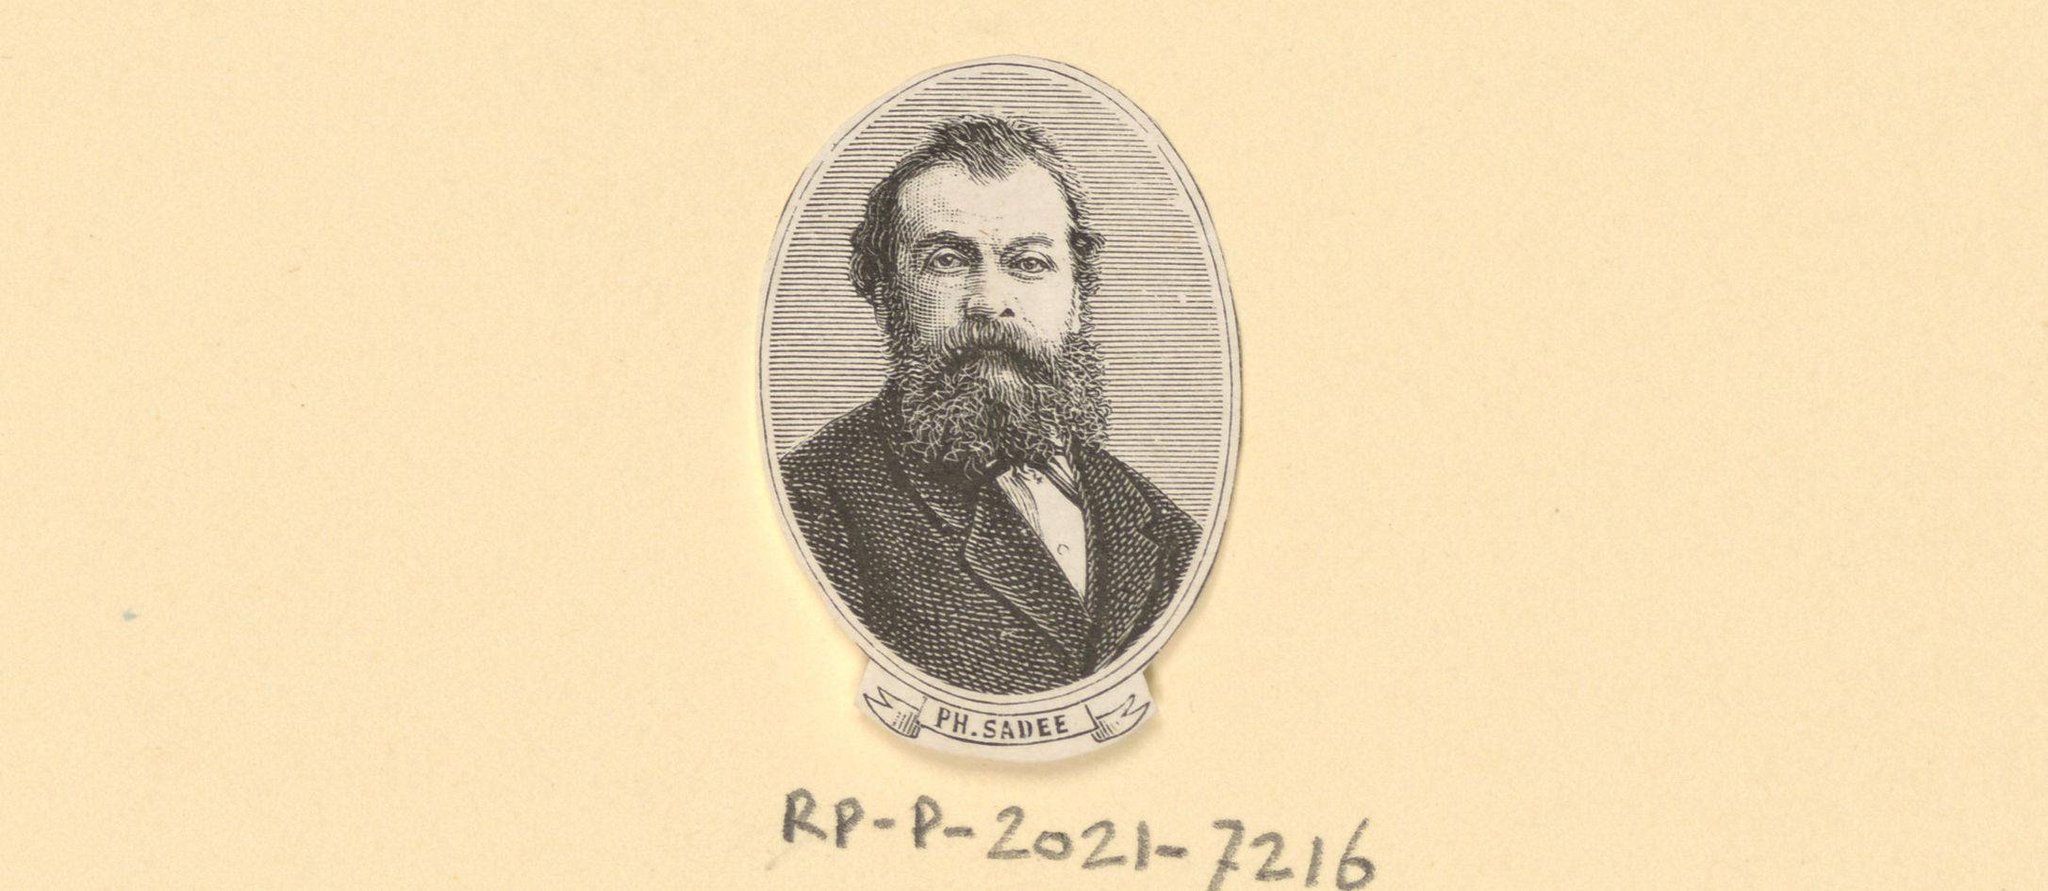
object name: print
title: Portret van Philip Sadée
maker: Anonymous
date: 1857-1899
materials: paper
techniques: engraving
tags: the hague, painter, print maker, draughtsman, philip sadée, historical persons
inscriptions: collector's mark: Lugt 2760, collector's mark: Lugt 2228